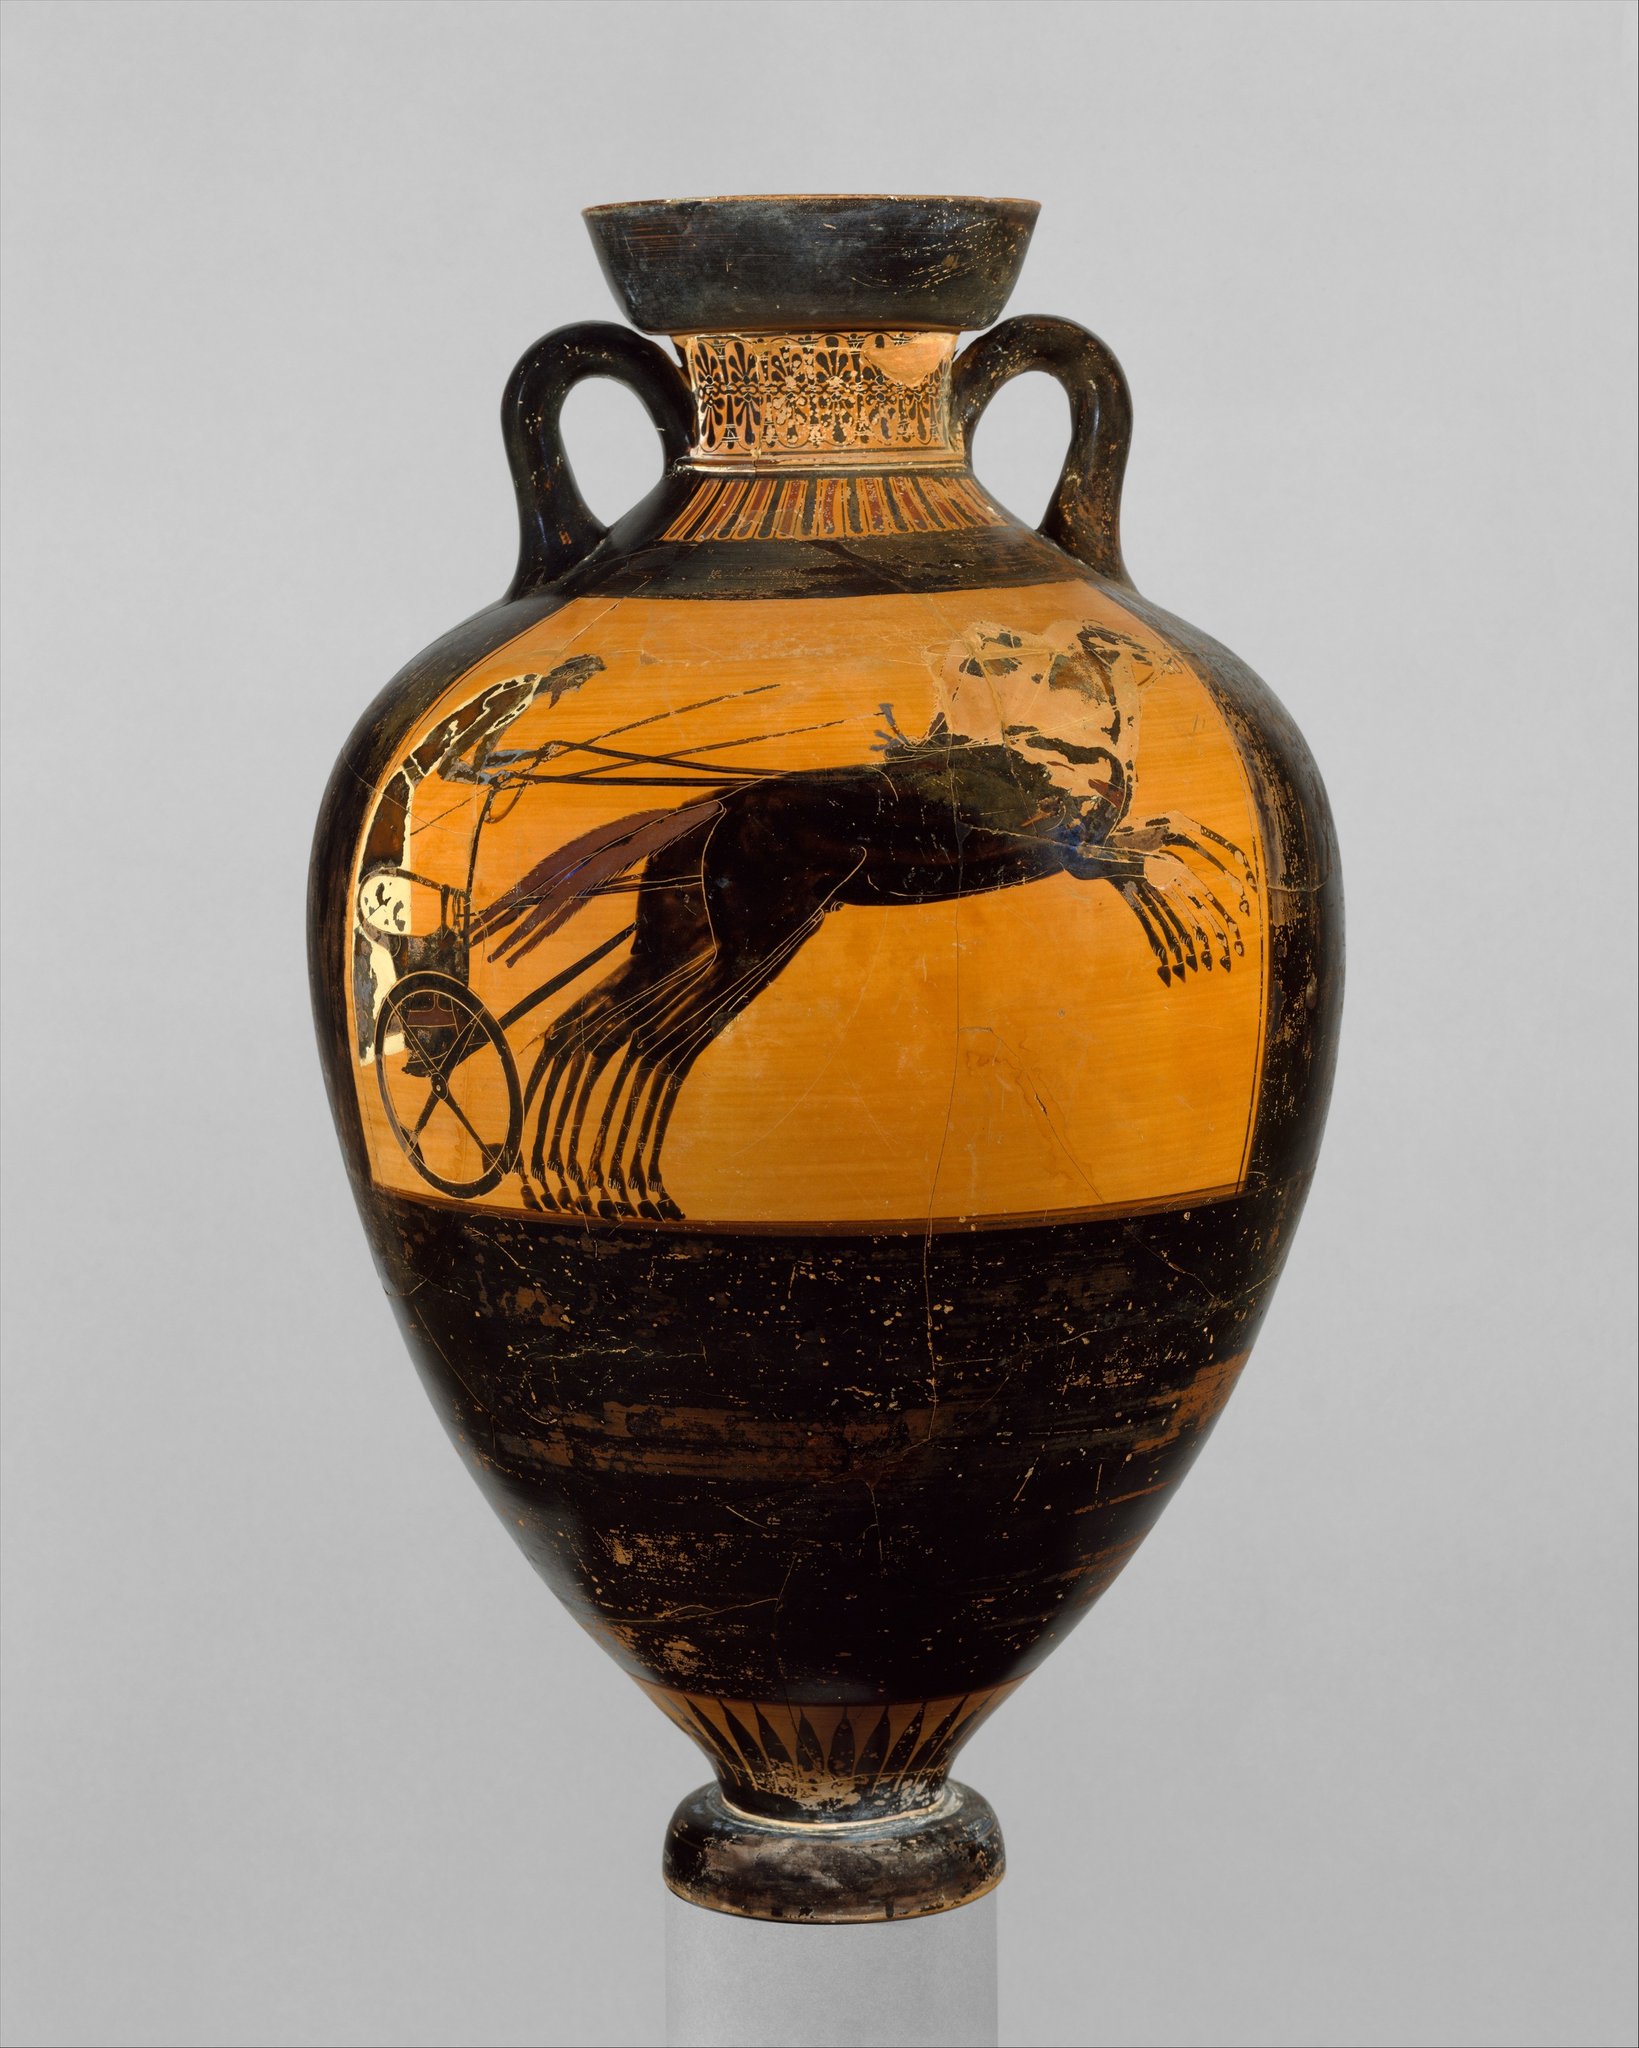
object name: panathenaic prize amphora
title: Terracotta Panathenaic prize amphora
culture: greek, attic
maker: kleophrades painter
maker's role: artist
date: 525-500 BCE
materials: terracotta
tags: shields,men,athena,horses,chariots